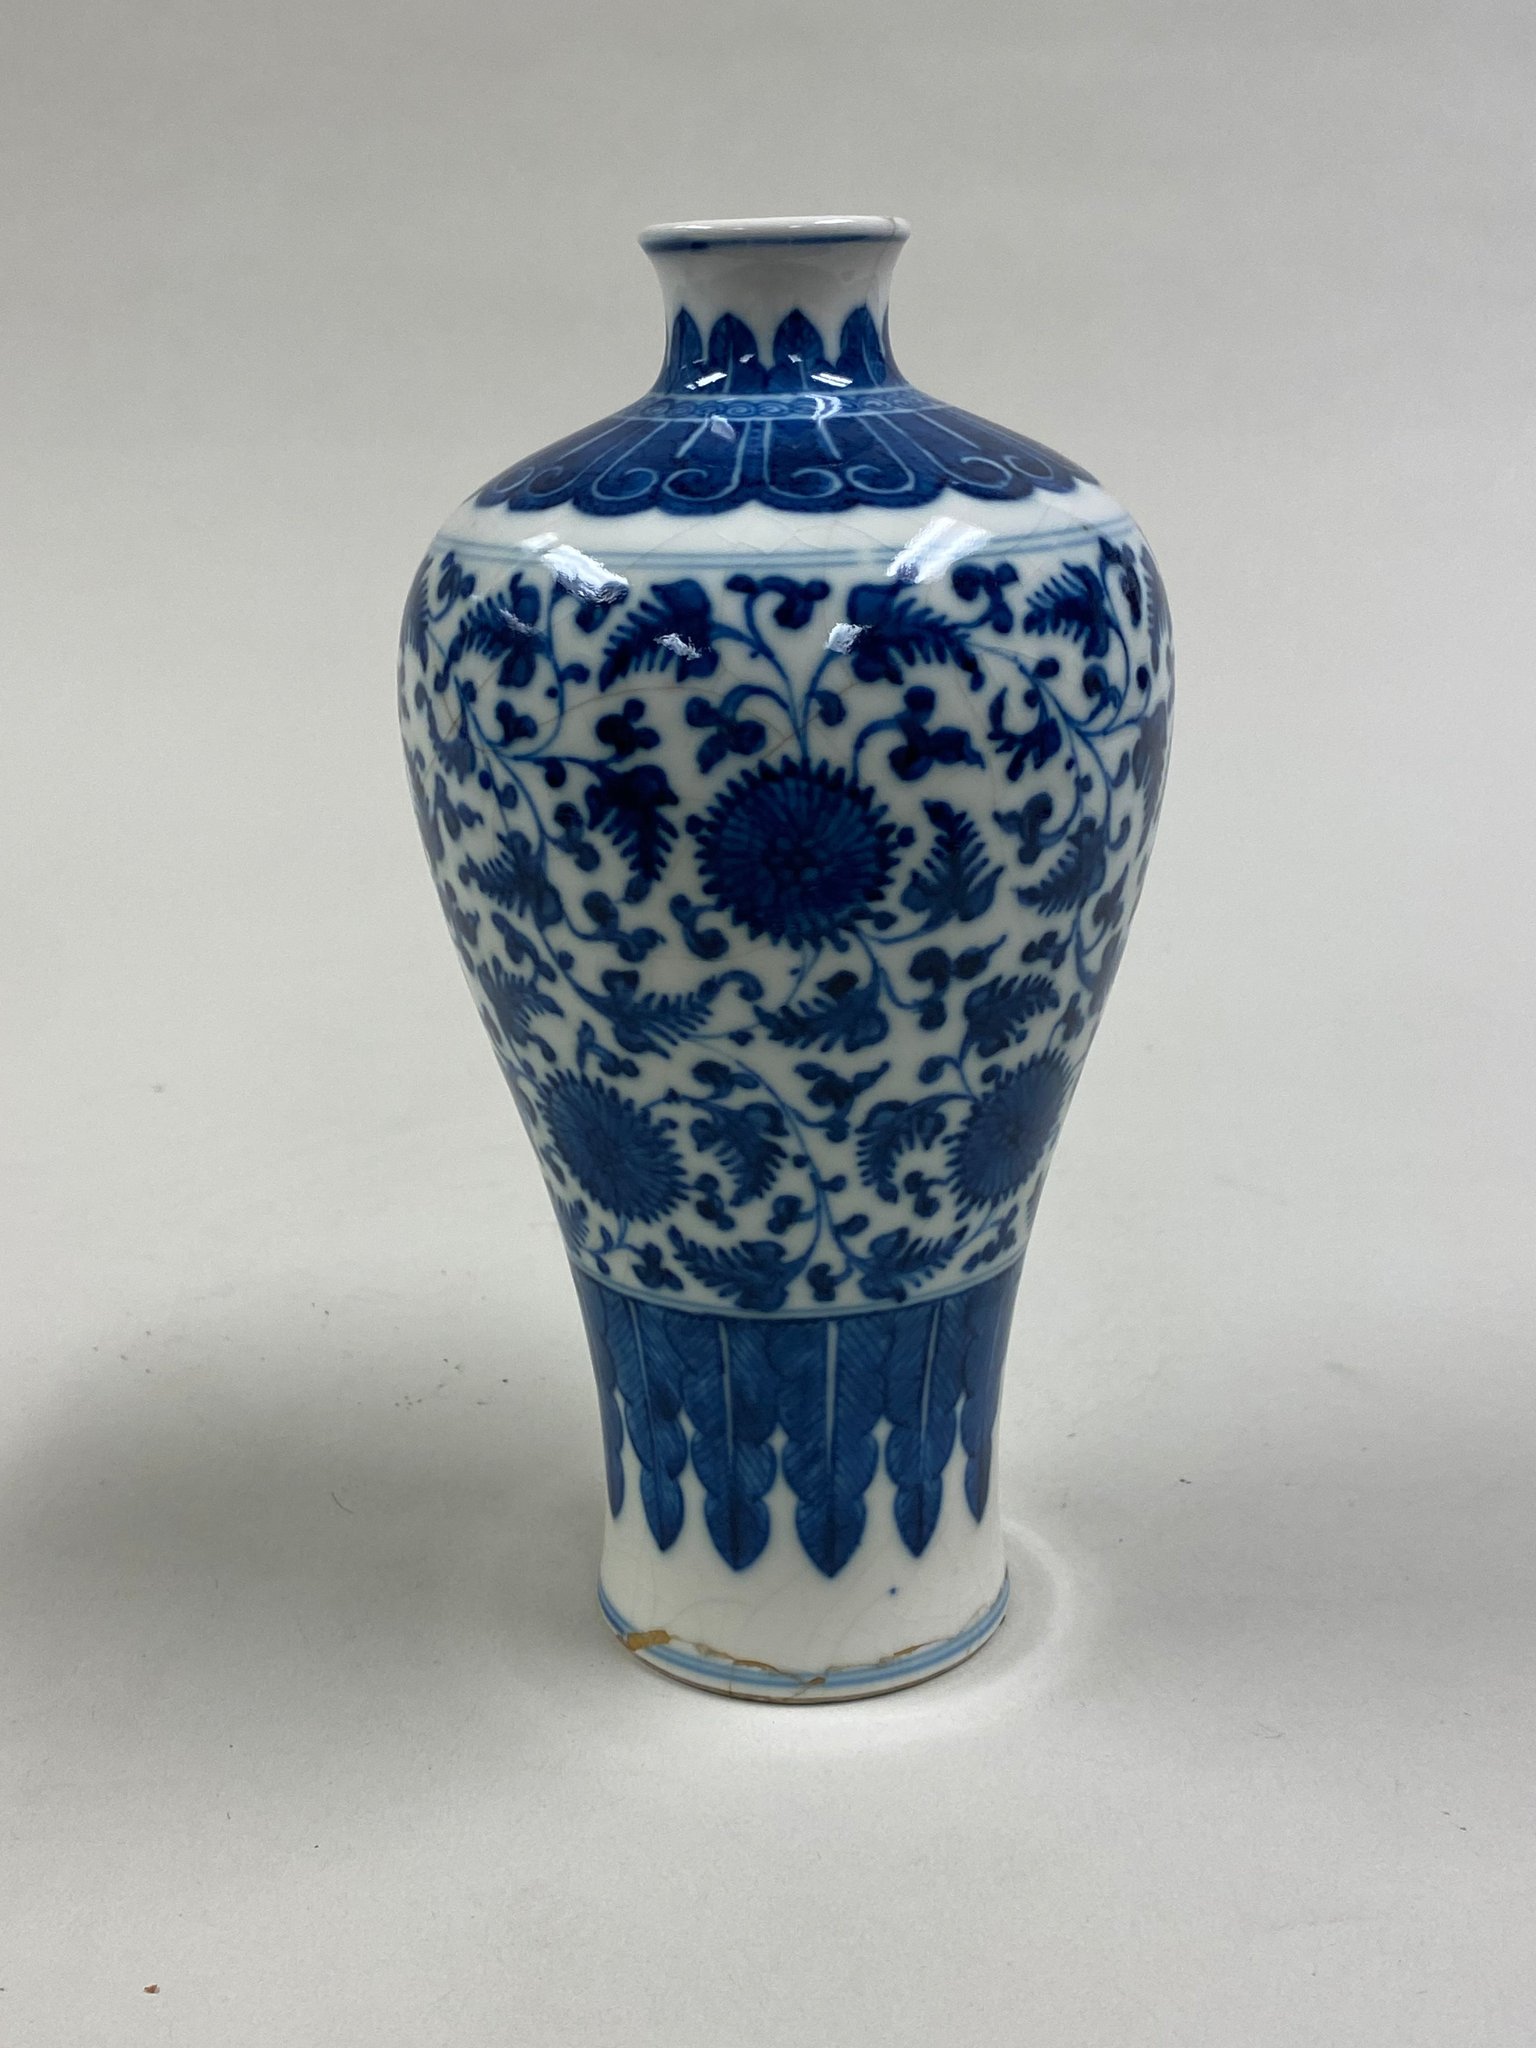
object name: vase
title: Meiping vase with floral scrolls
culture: chinese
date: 1701-1733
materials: cobalt, soft paste porcelain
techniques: underglaze